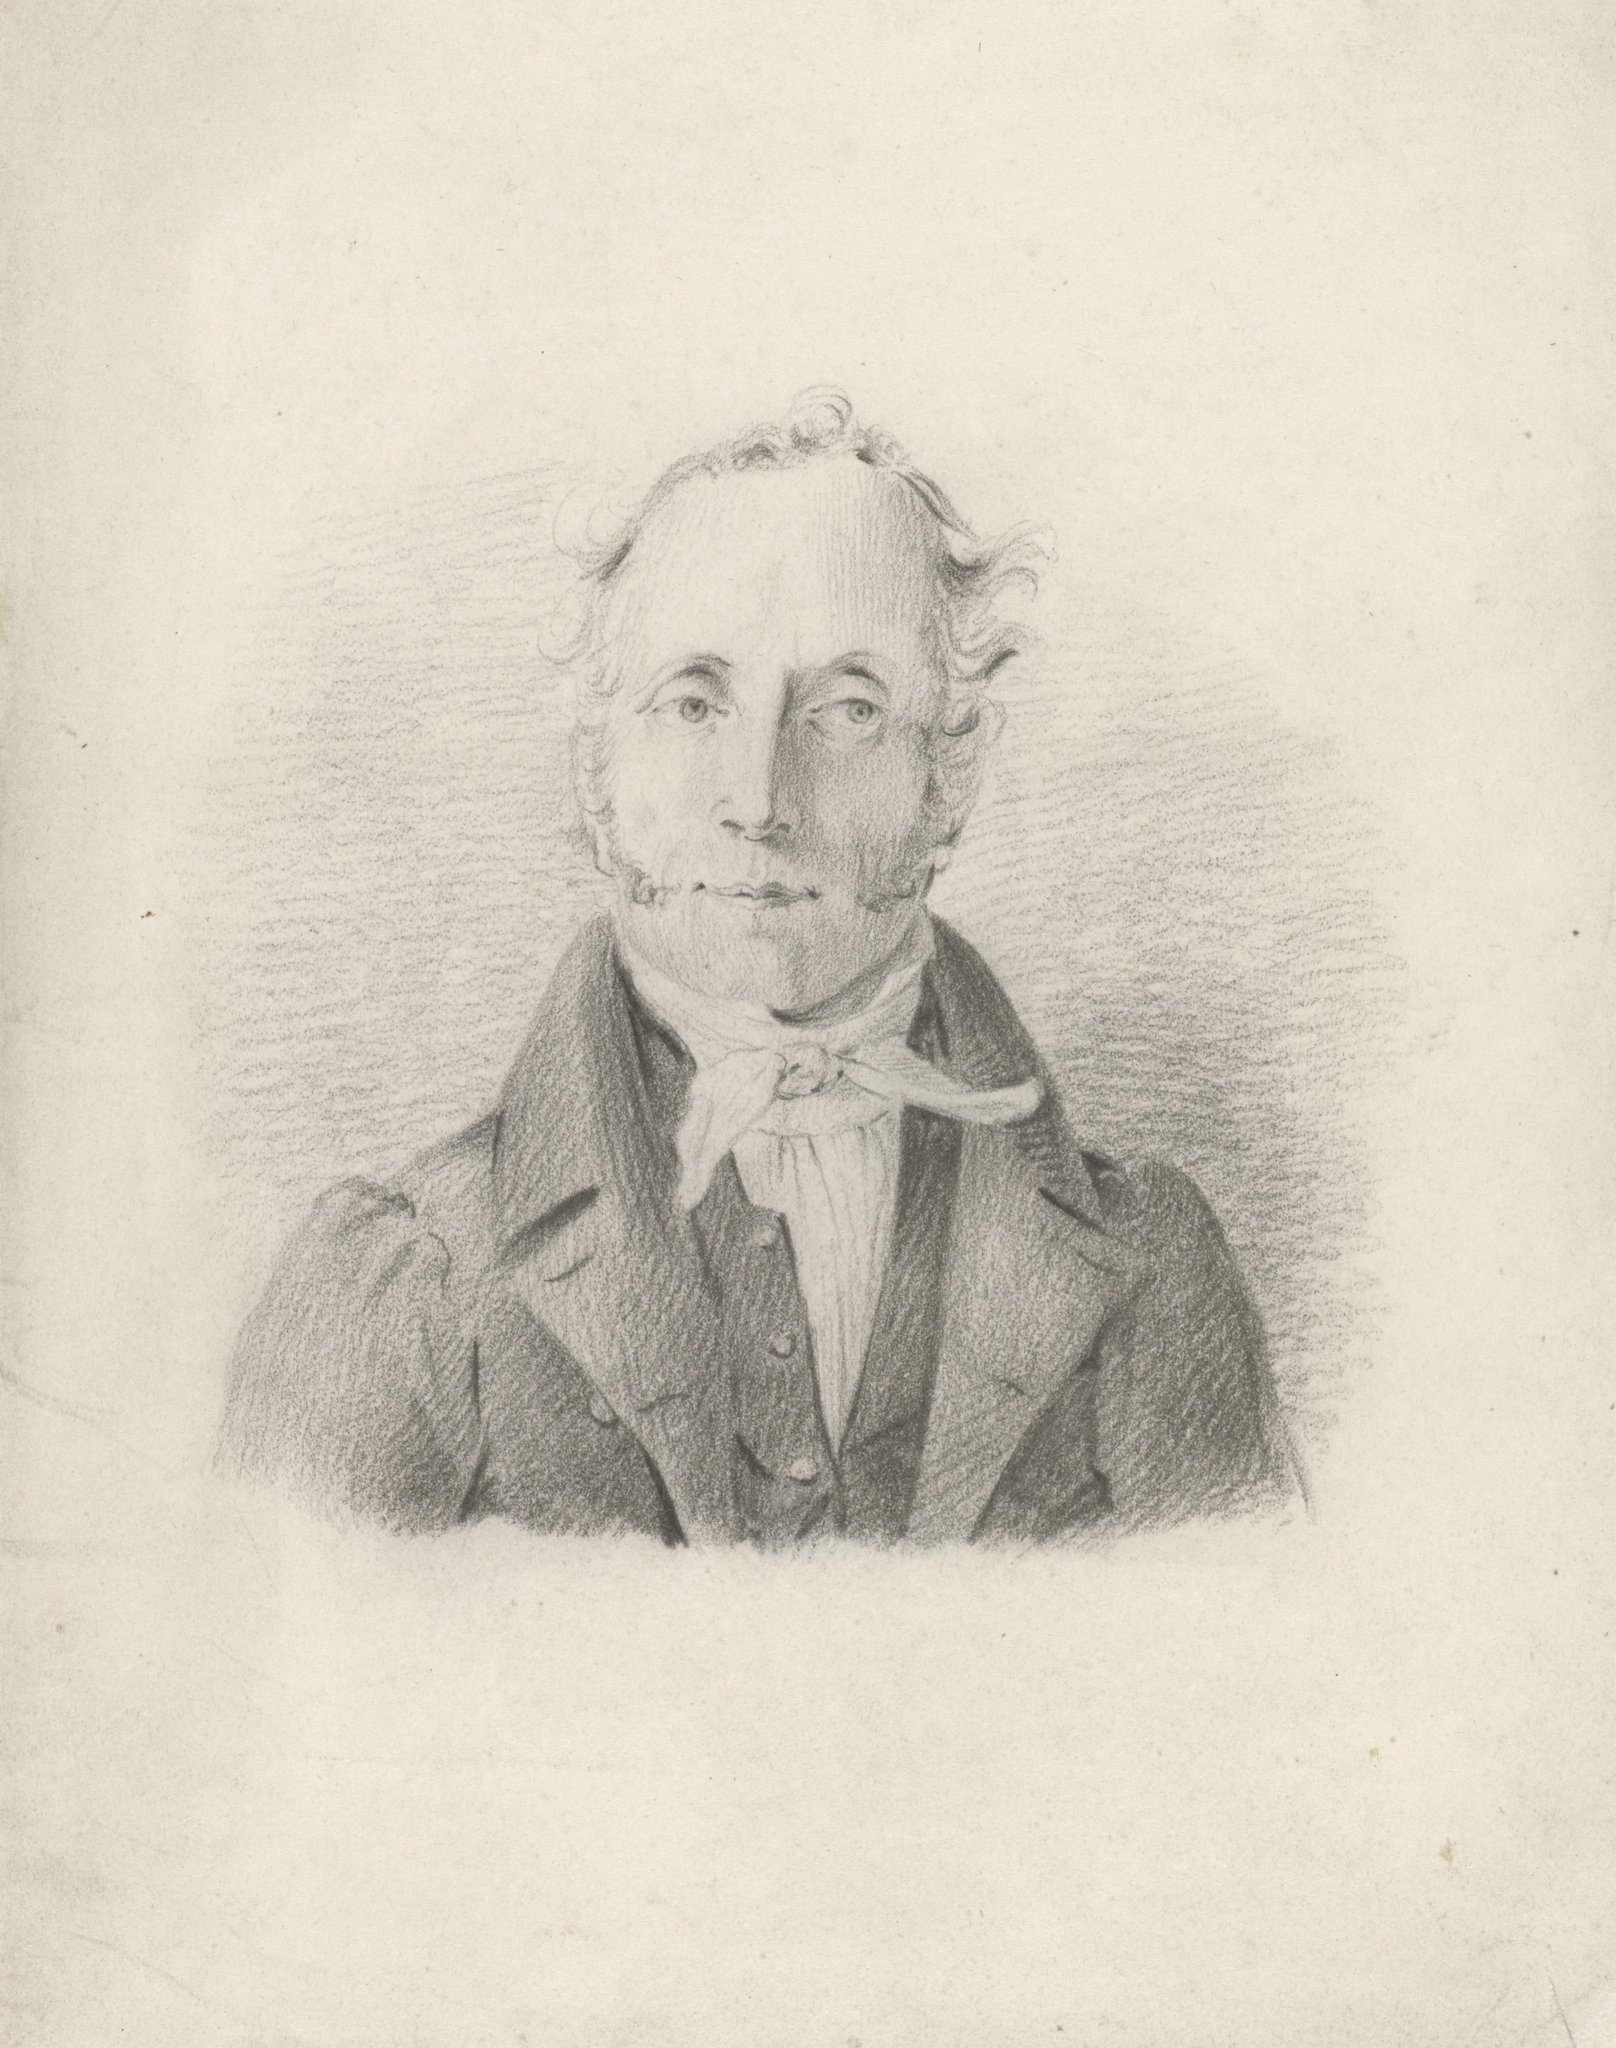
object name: drawing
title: Mansportret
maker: alexander cranendoncq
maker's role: draughtsman, print maker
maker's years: 1799-1869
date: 1809-1869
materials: chalk, paper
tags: anonymous historical person portrayed alone